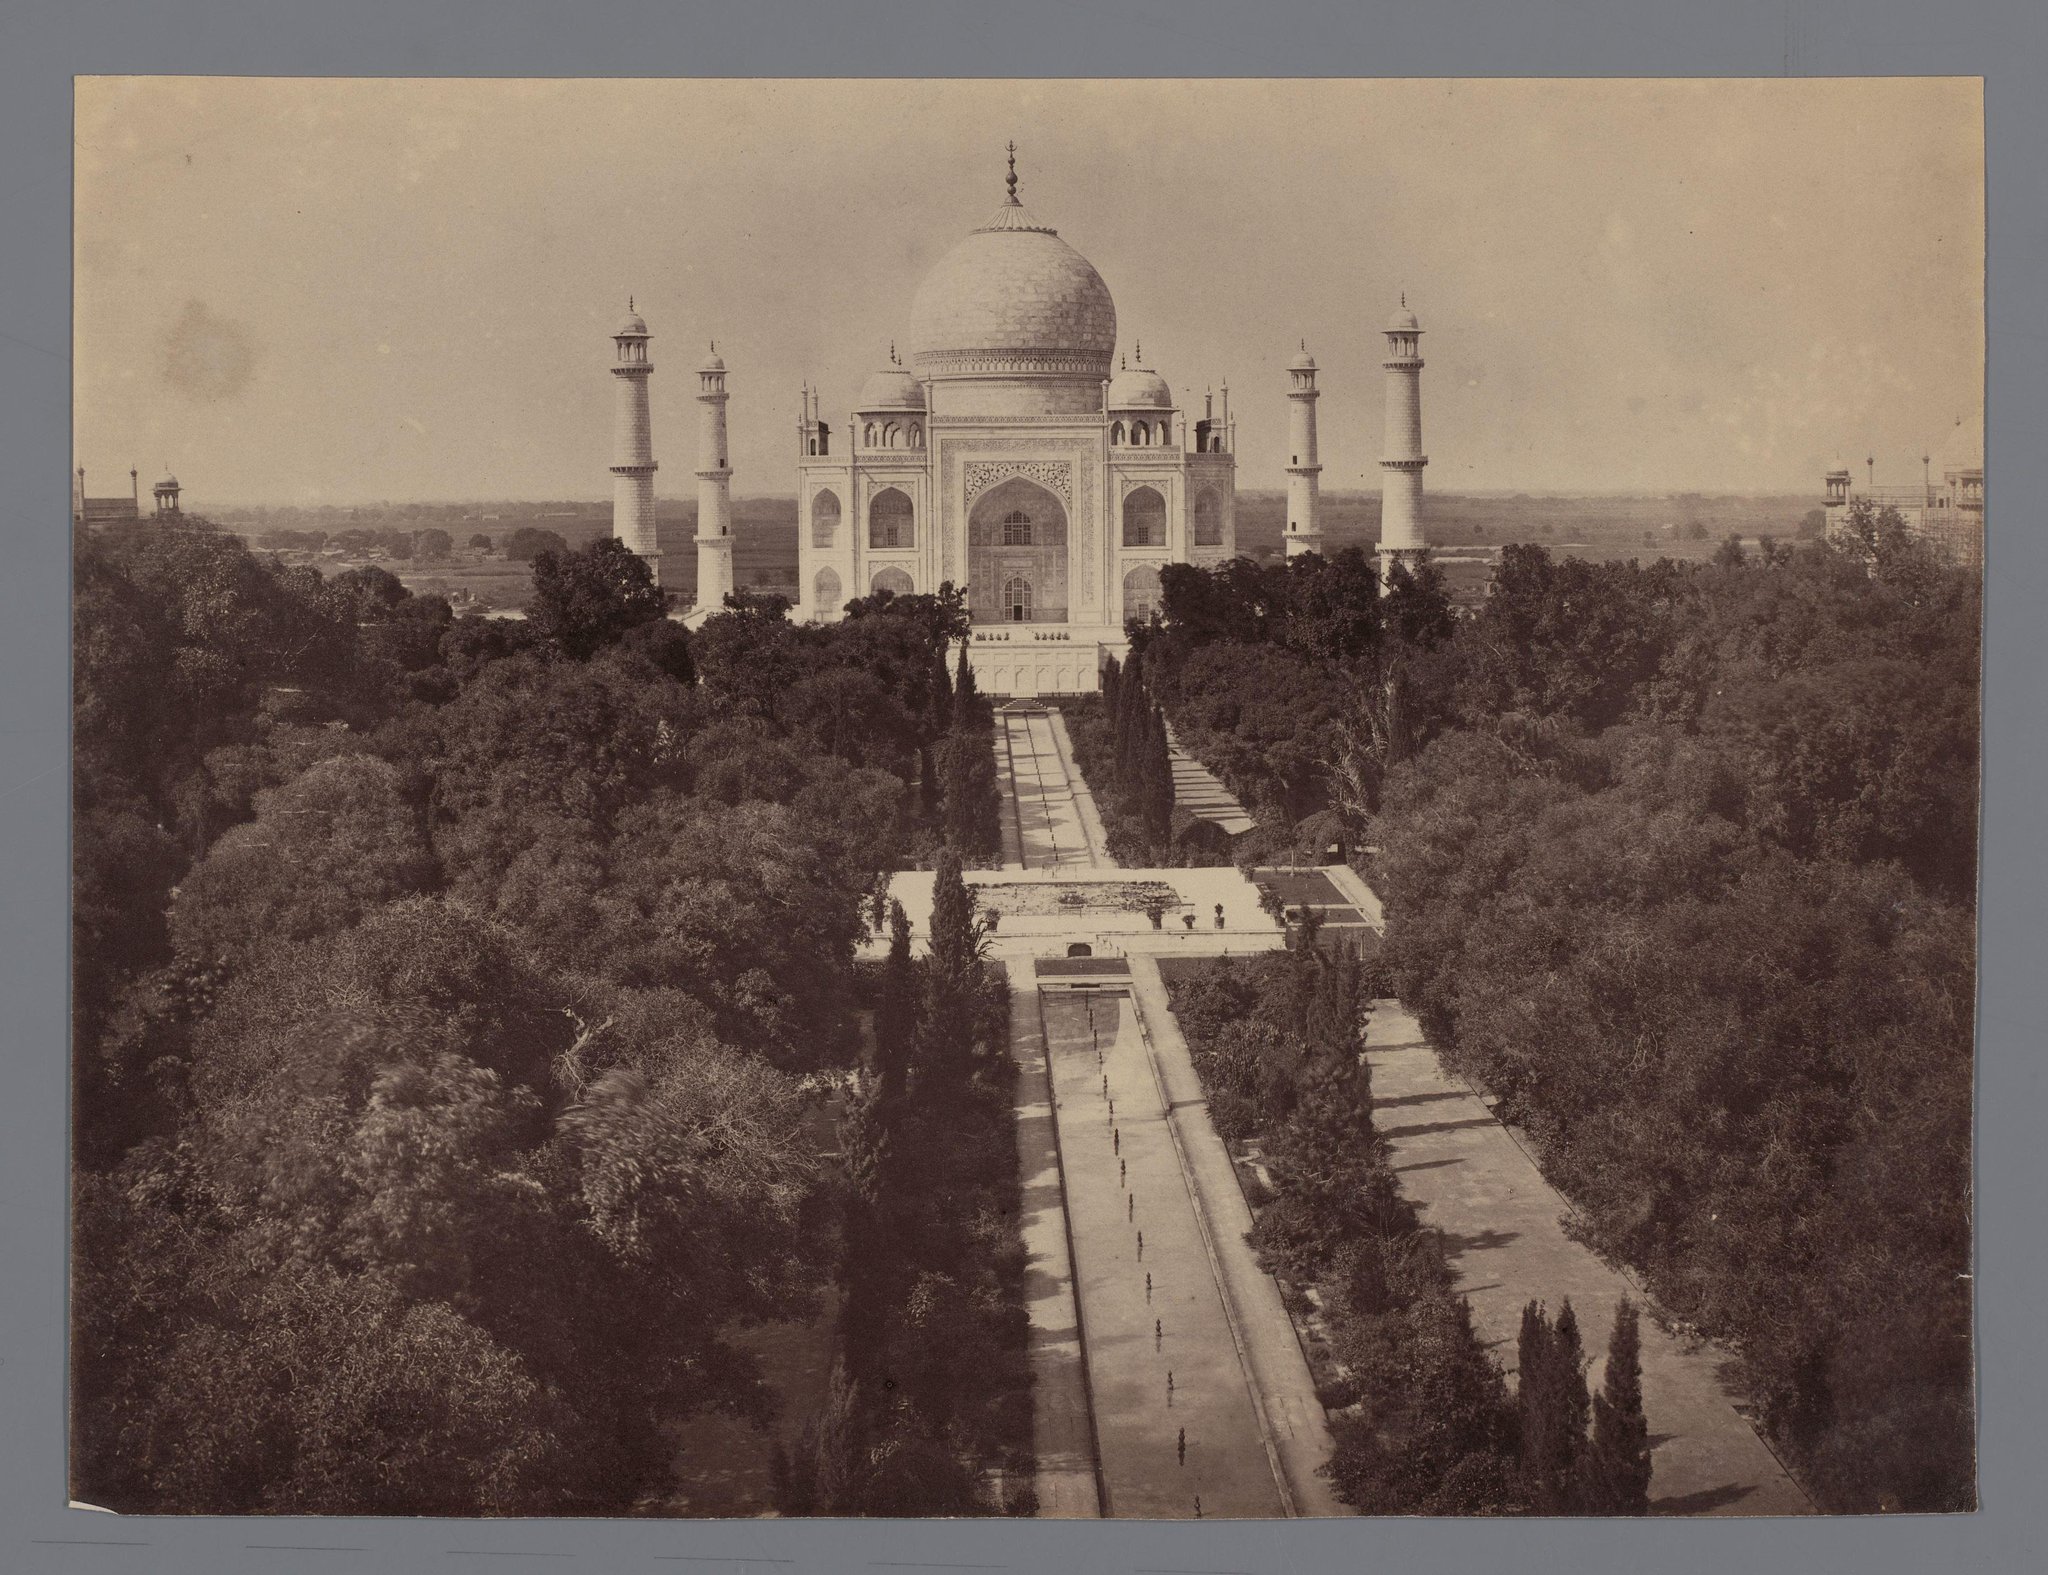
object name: photograph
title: View of the Taj Mahal with trees on the foreground, Agra, Uttar Pradesh, India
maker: Anonymous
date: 1875-1900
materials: paper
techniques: albumen print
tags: taj mahal, agra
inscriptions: title (): ‘Agra. The Taj’, number (false): ‘23’